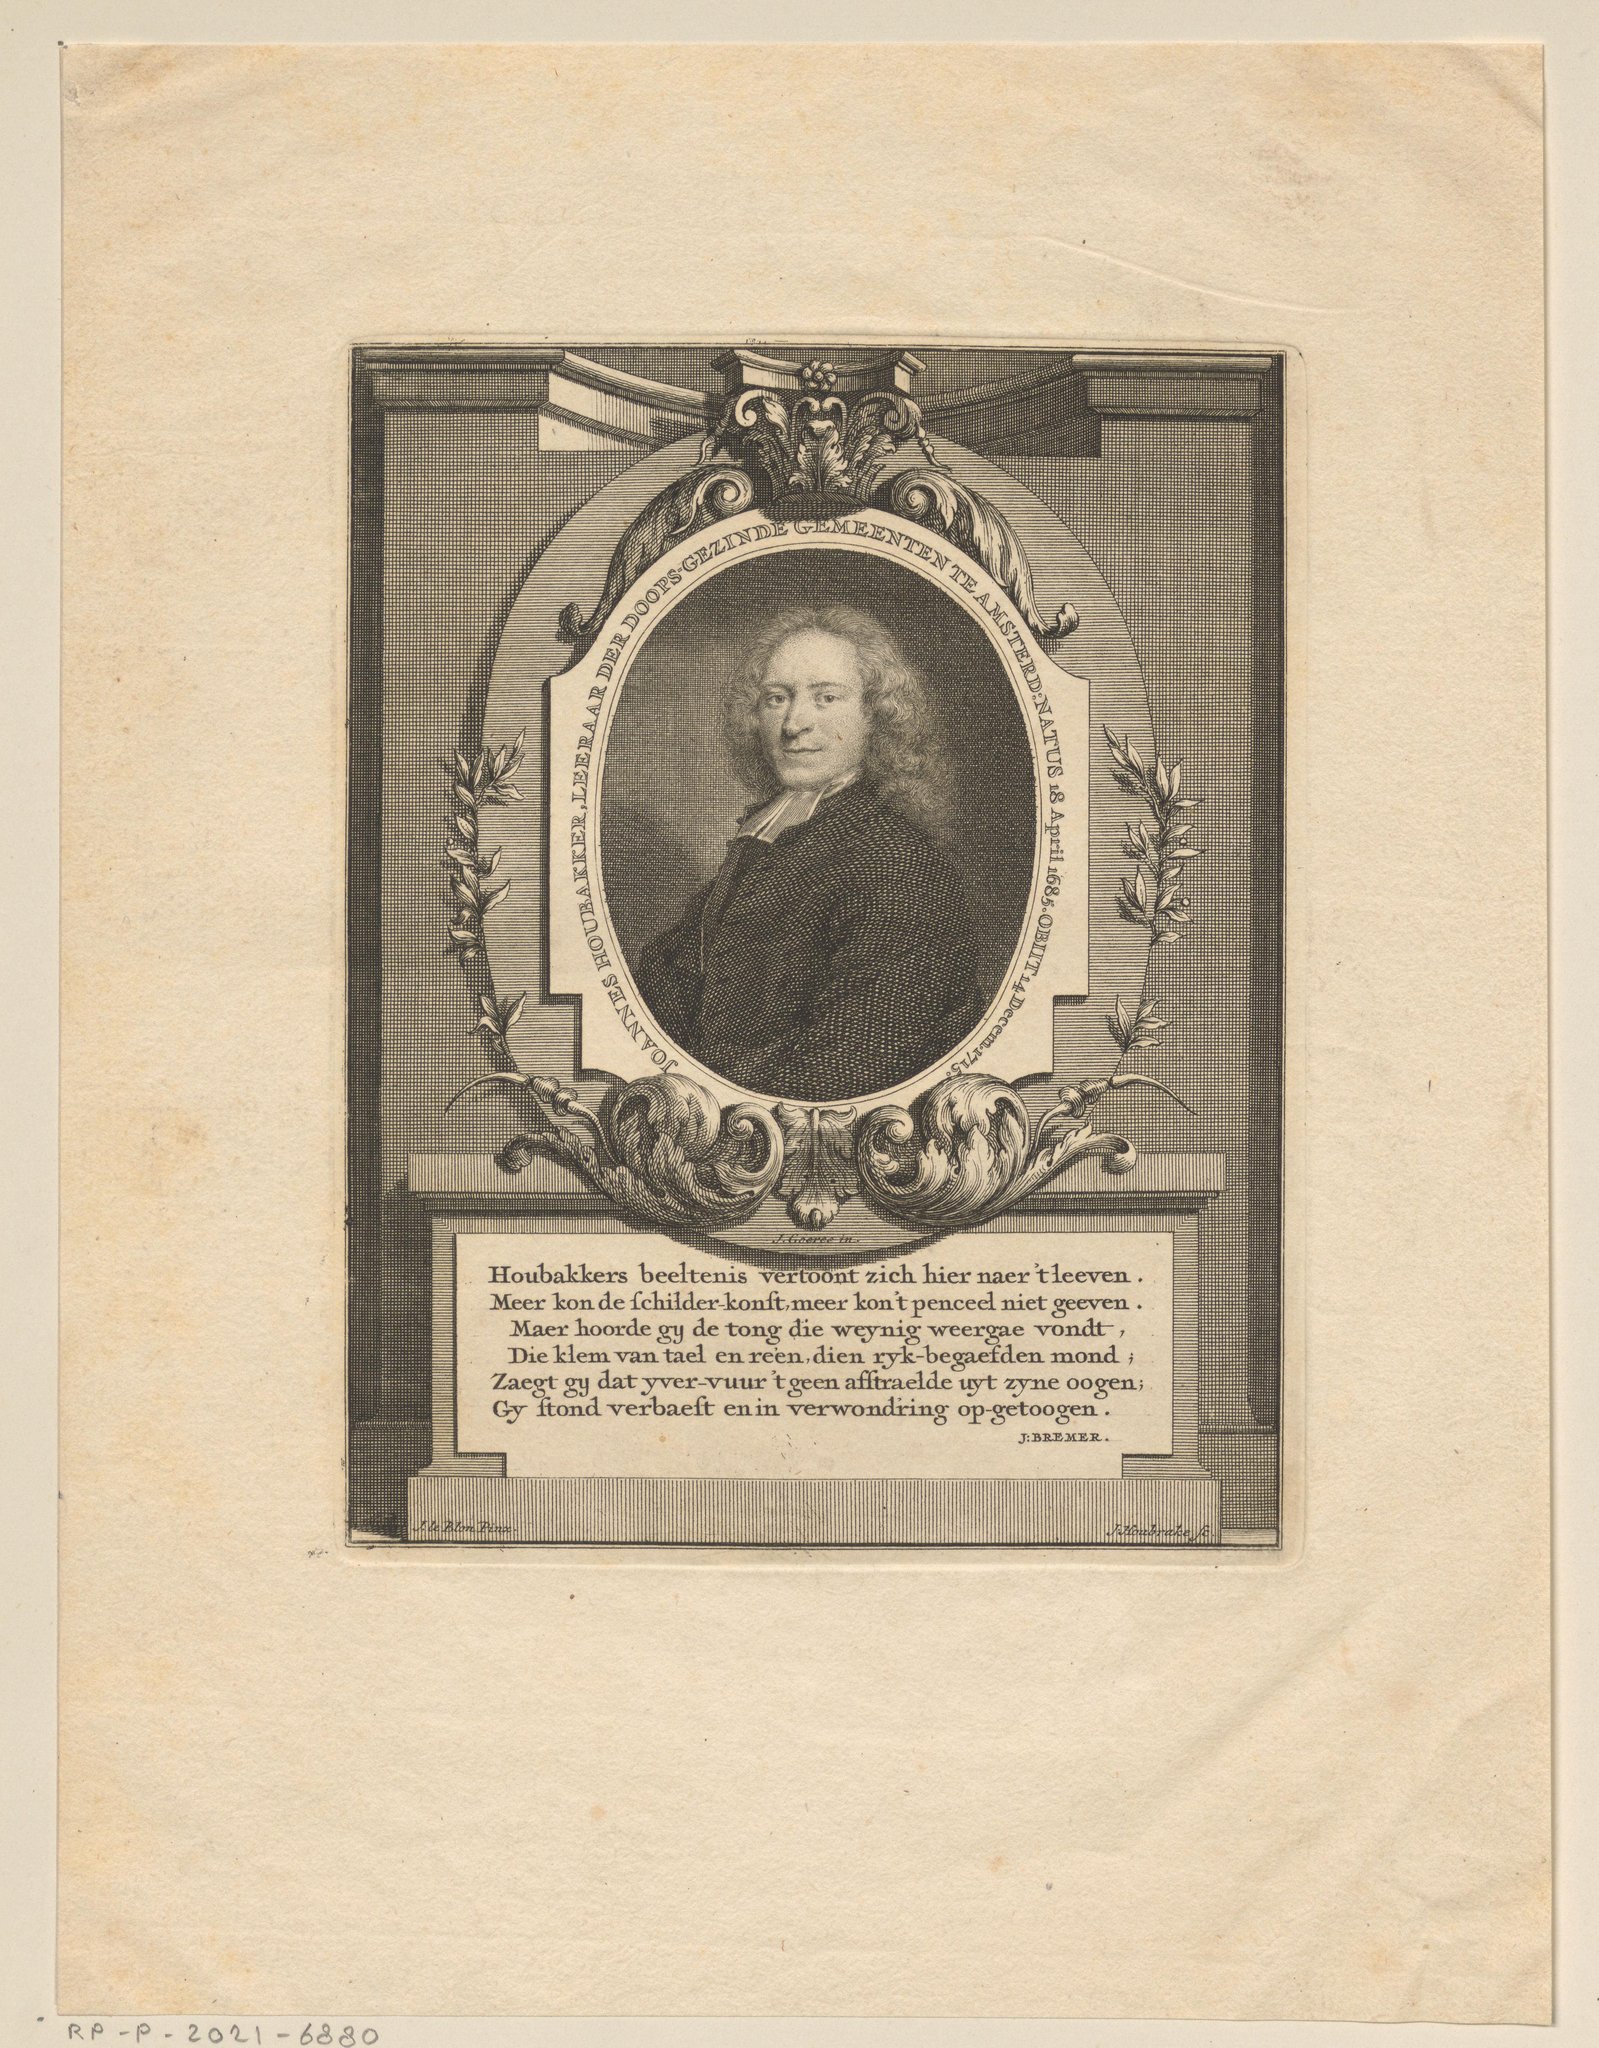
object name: print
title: Portret van Joannes Houbakker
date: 1715-1780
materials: paper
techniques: engraving, etching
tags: amsterdam, historical persons, functionaries and dignitaries ~ episcopal protestant churches